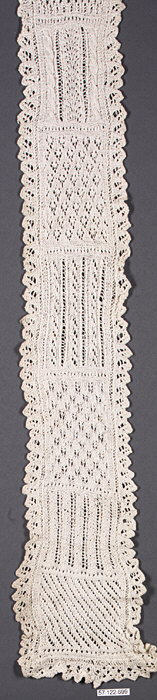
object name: sampler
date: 1801-1900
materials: cotton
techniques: crochet